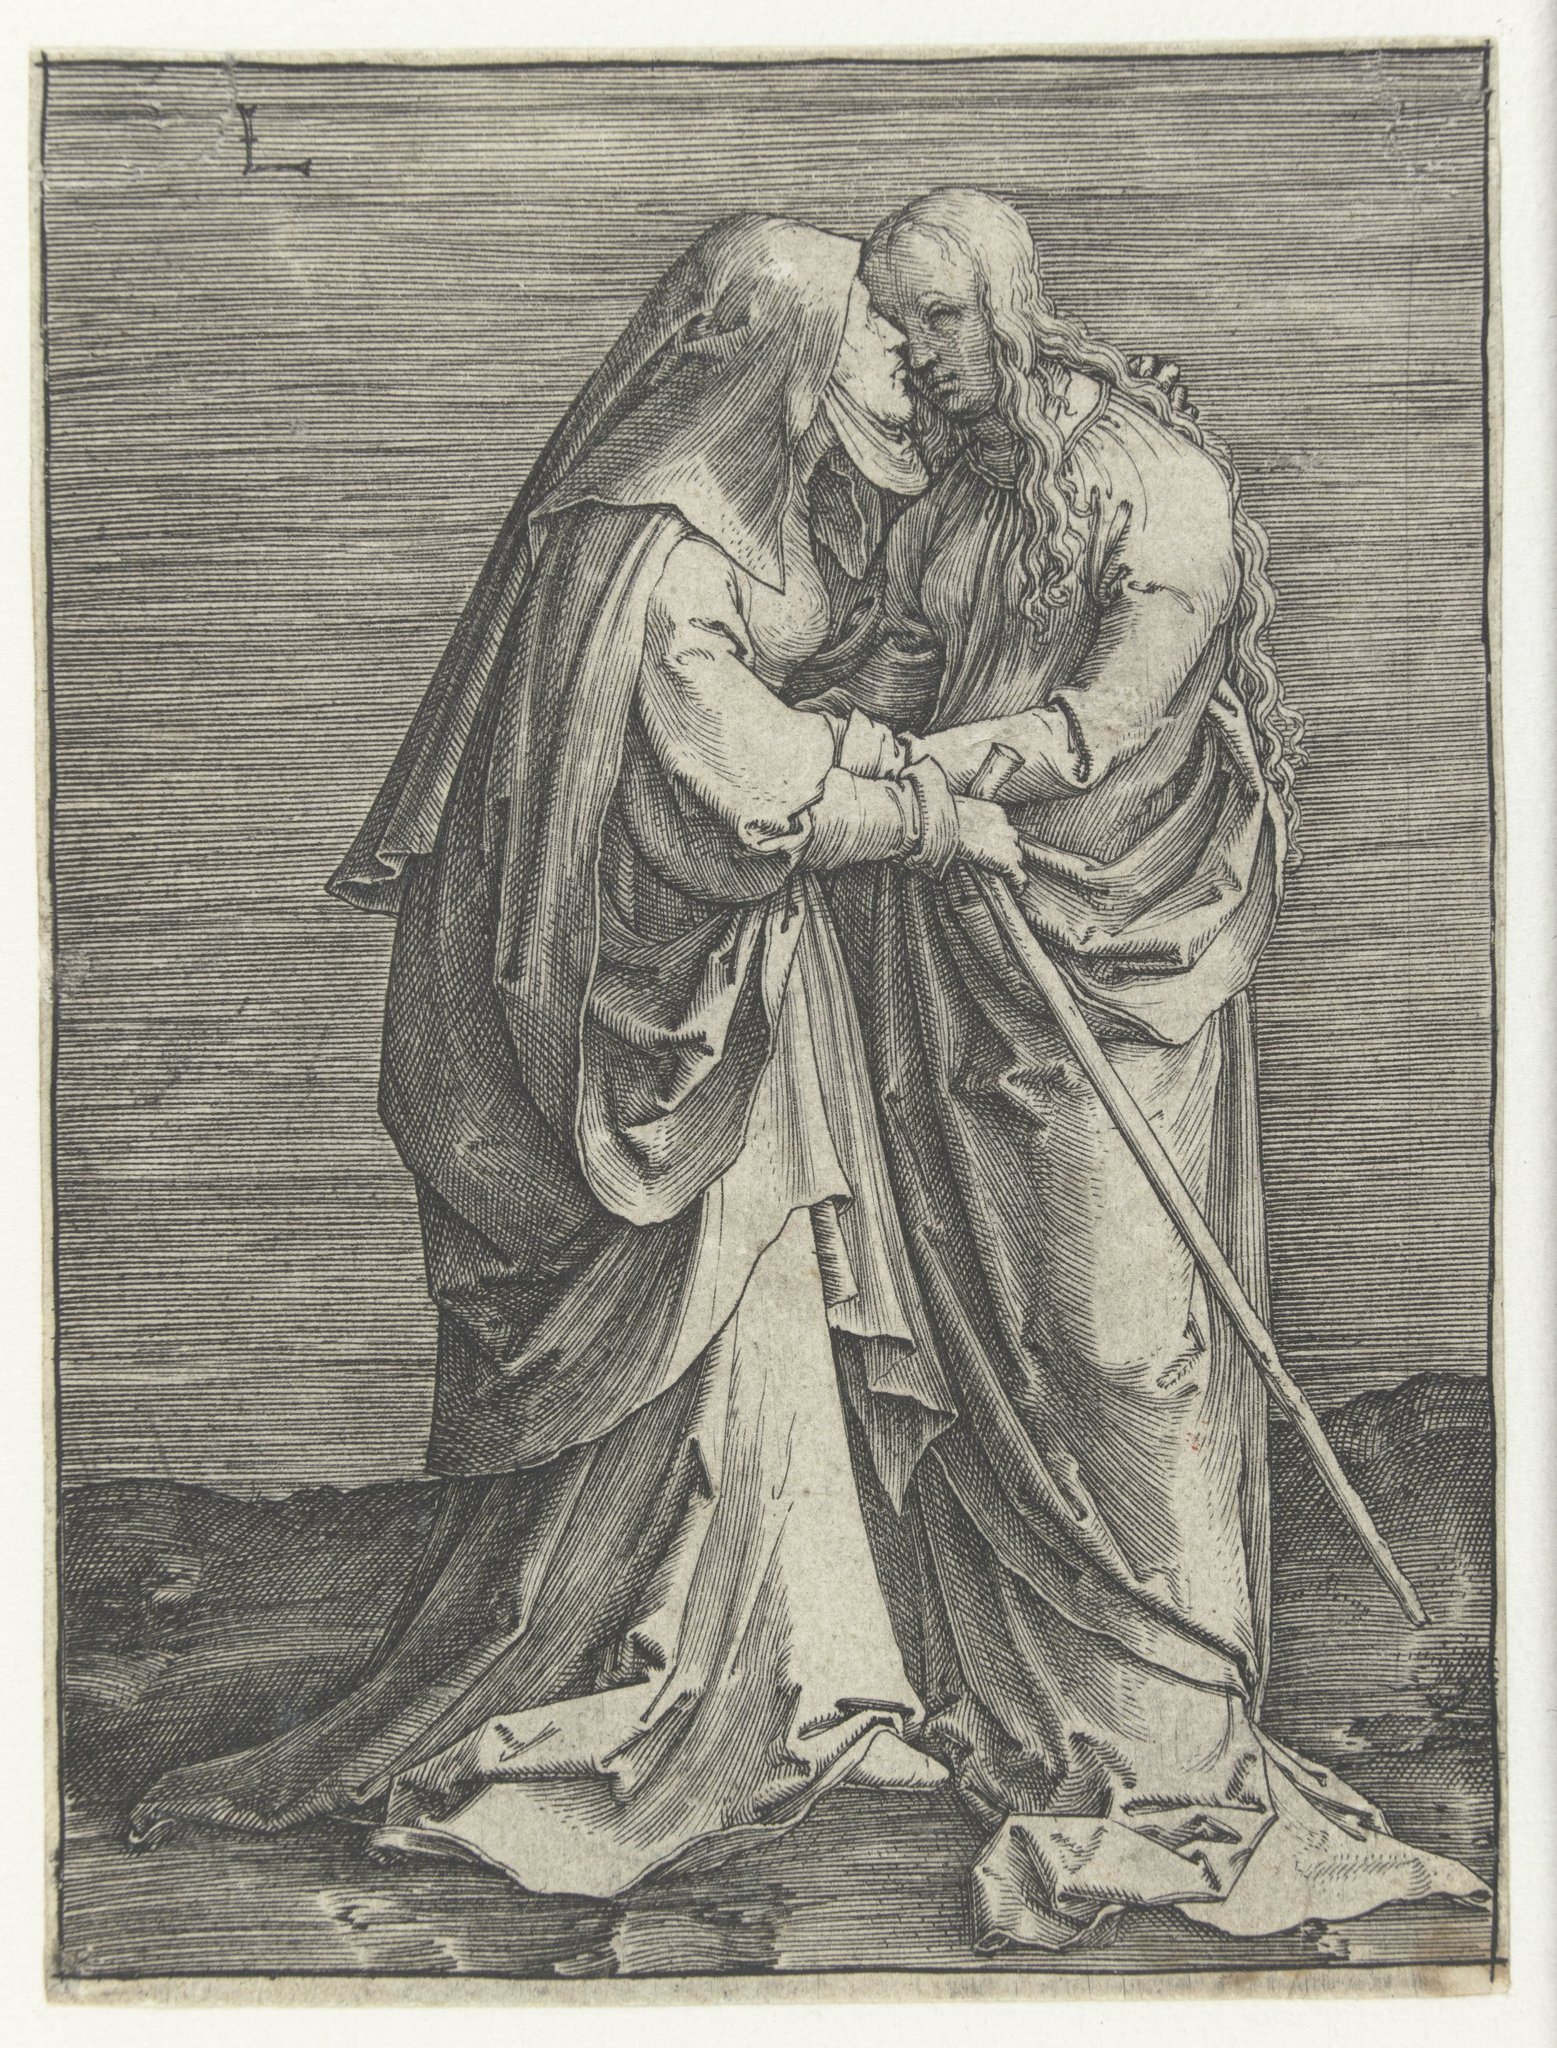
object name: print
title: De visitatie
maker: lucas van leyden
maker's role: draughtsman, painter, print maker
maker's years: 1494-1533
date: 1514-1518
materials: paper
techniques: engraving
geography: low countries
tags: mary and elisabeth, both pregnant, embracing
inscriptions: collector's mark: Lugt 240